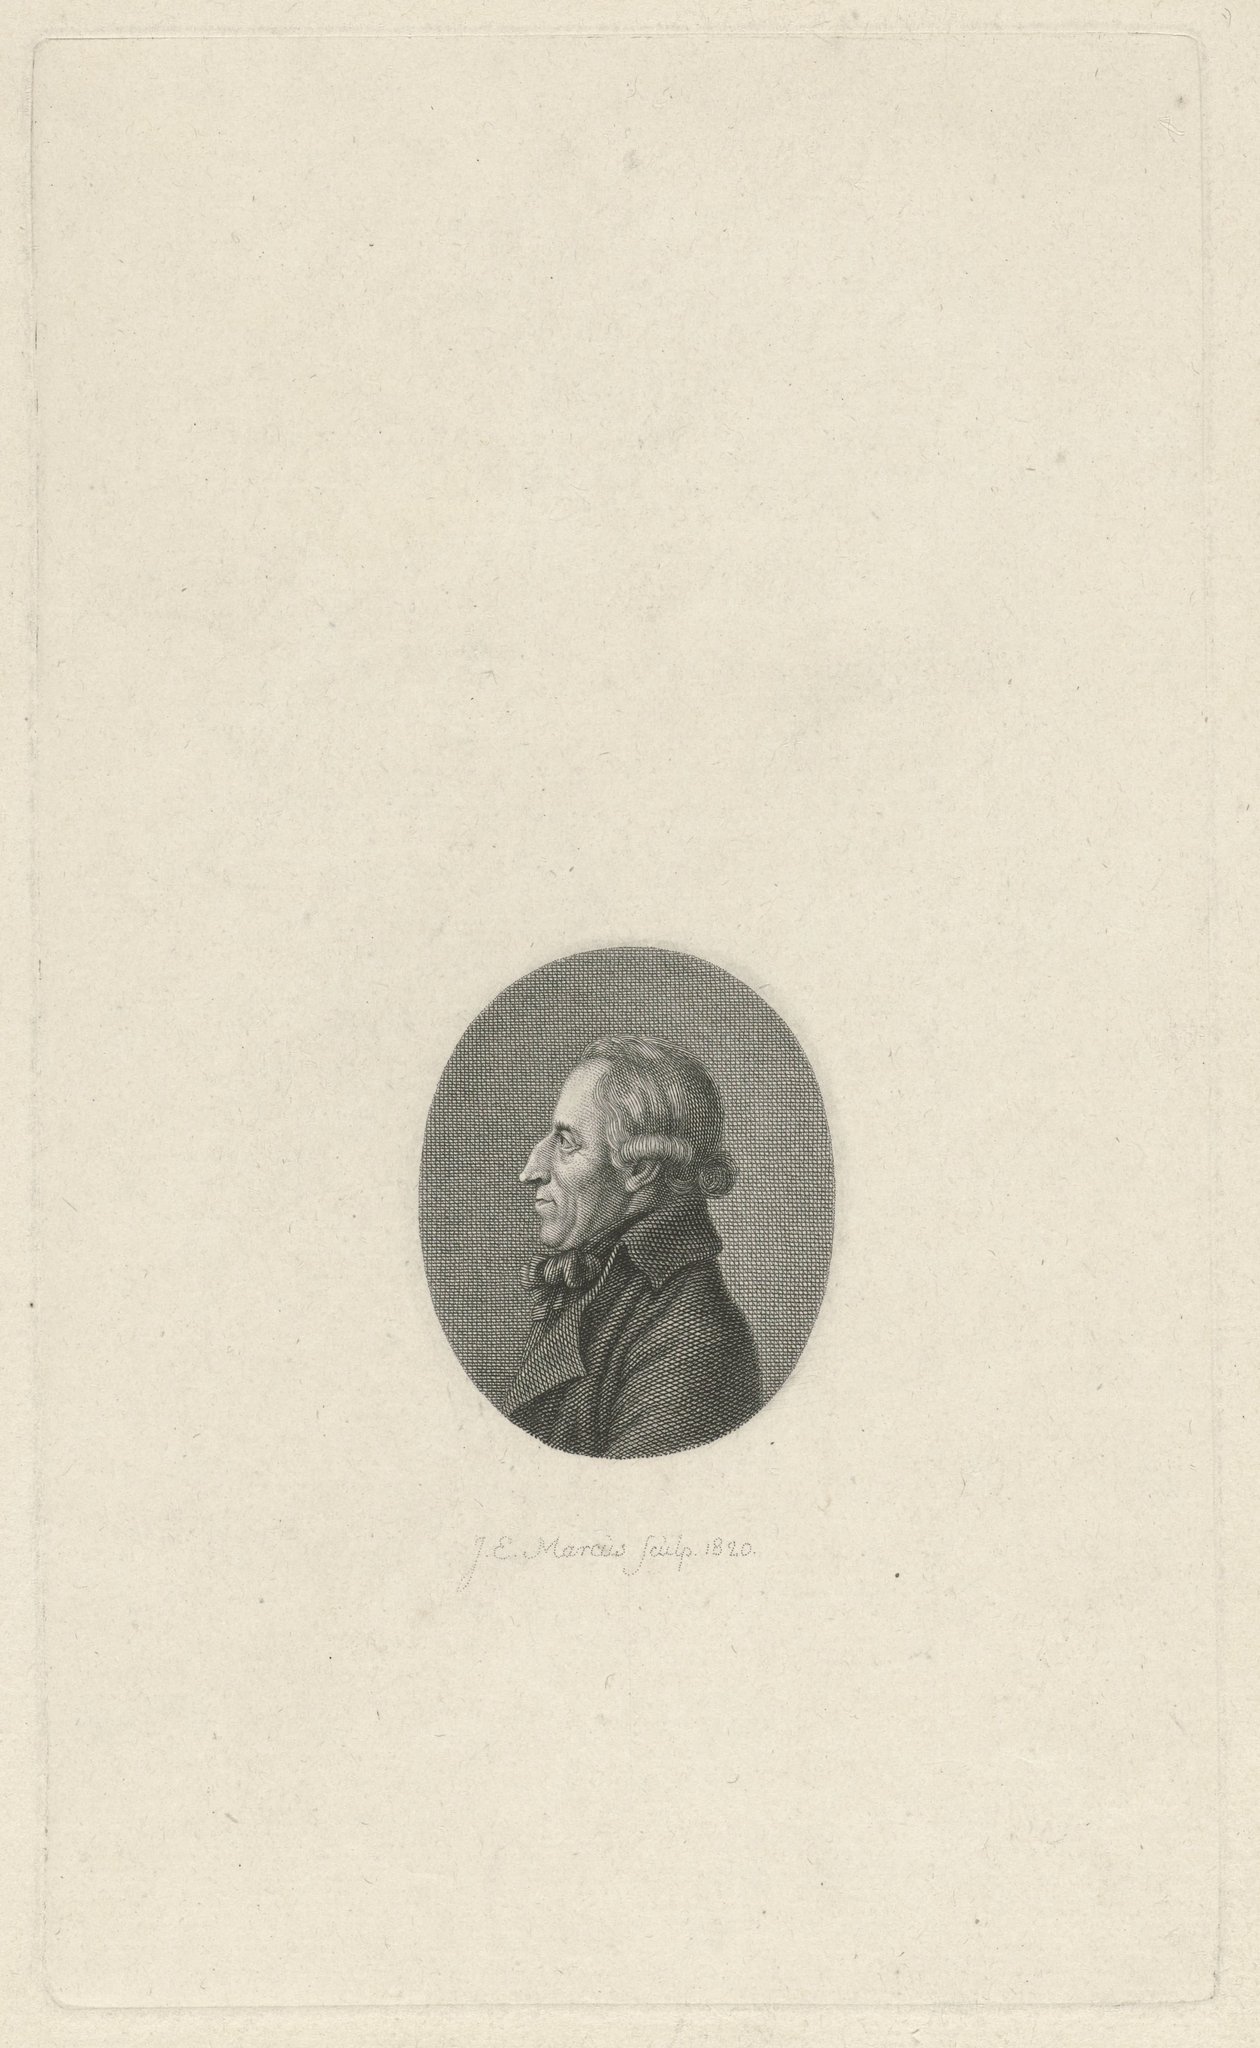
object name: print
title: Portret van Johann Jakob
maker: jacob ernst marcus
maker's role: draughtsman, print maker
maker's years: 1774-1826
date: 1820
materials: paper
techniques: etching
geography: amsterdam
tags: zürich (stad), theoloog, johann jakob hess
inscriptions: collector's mark: Lugt 2228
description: Buste van de Zwitserse theoloog Johann Jakob Hess.